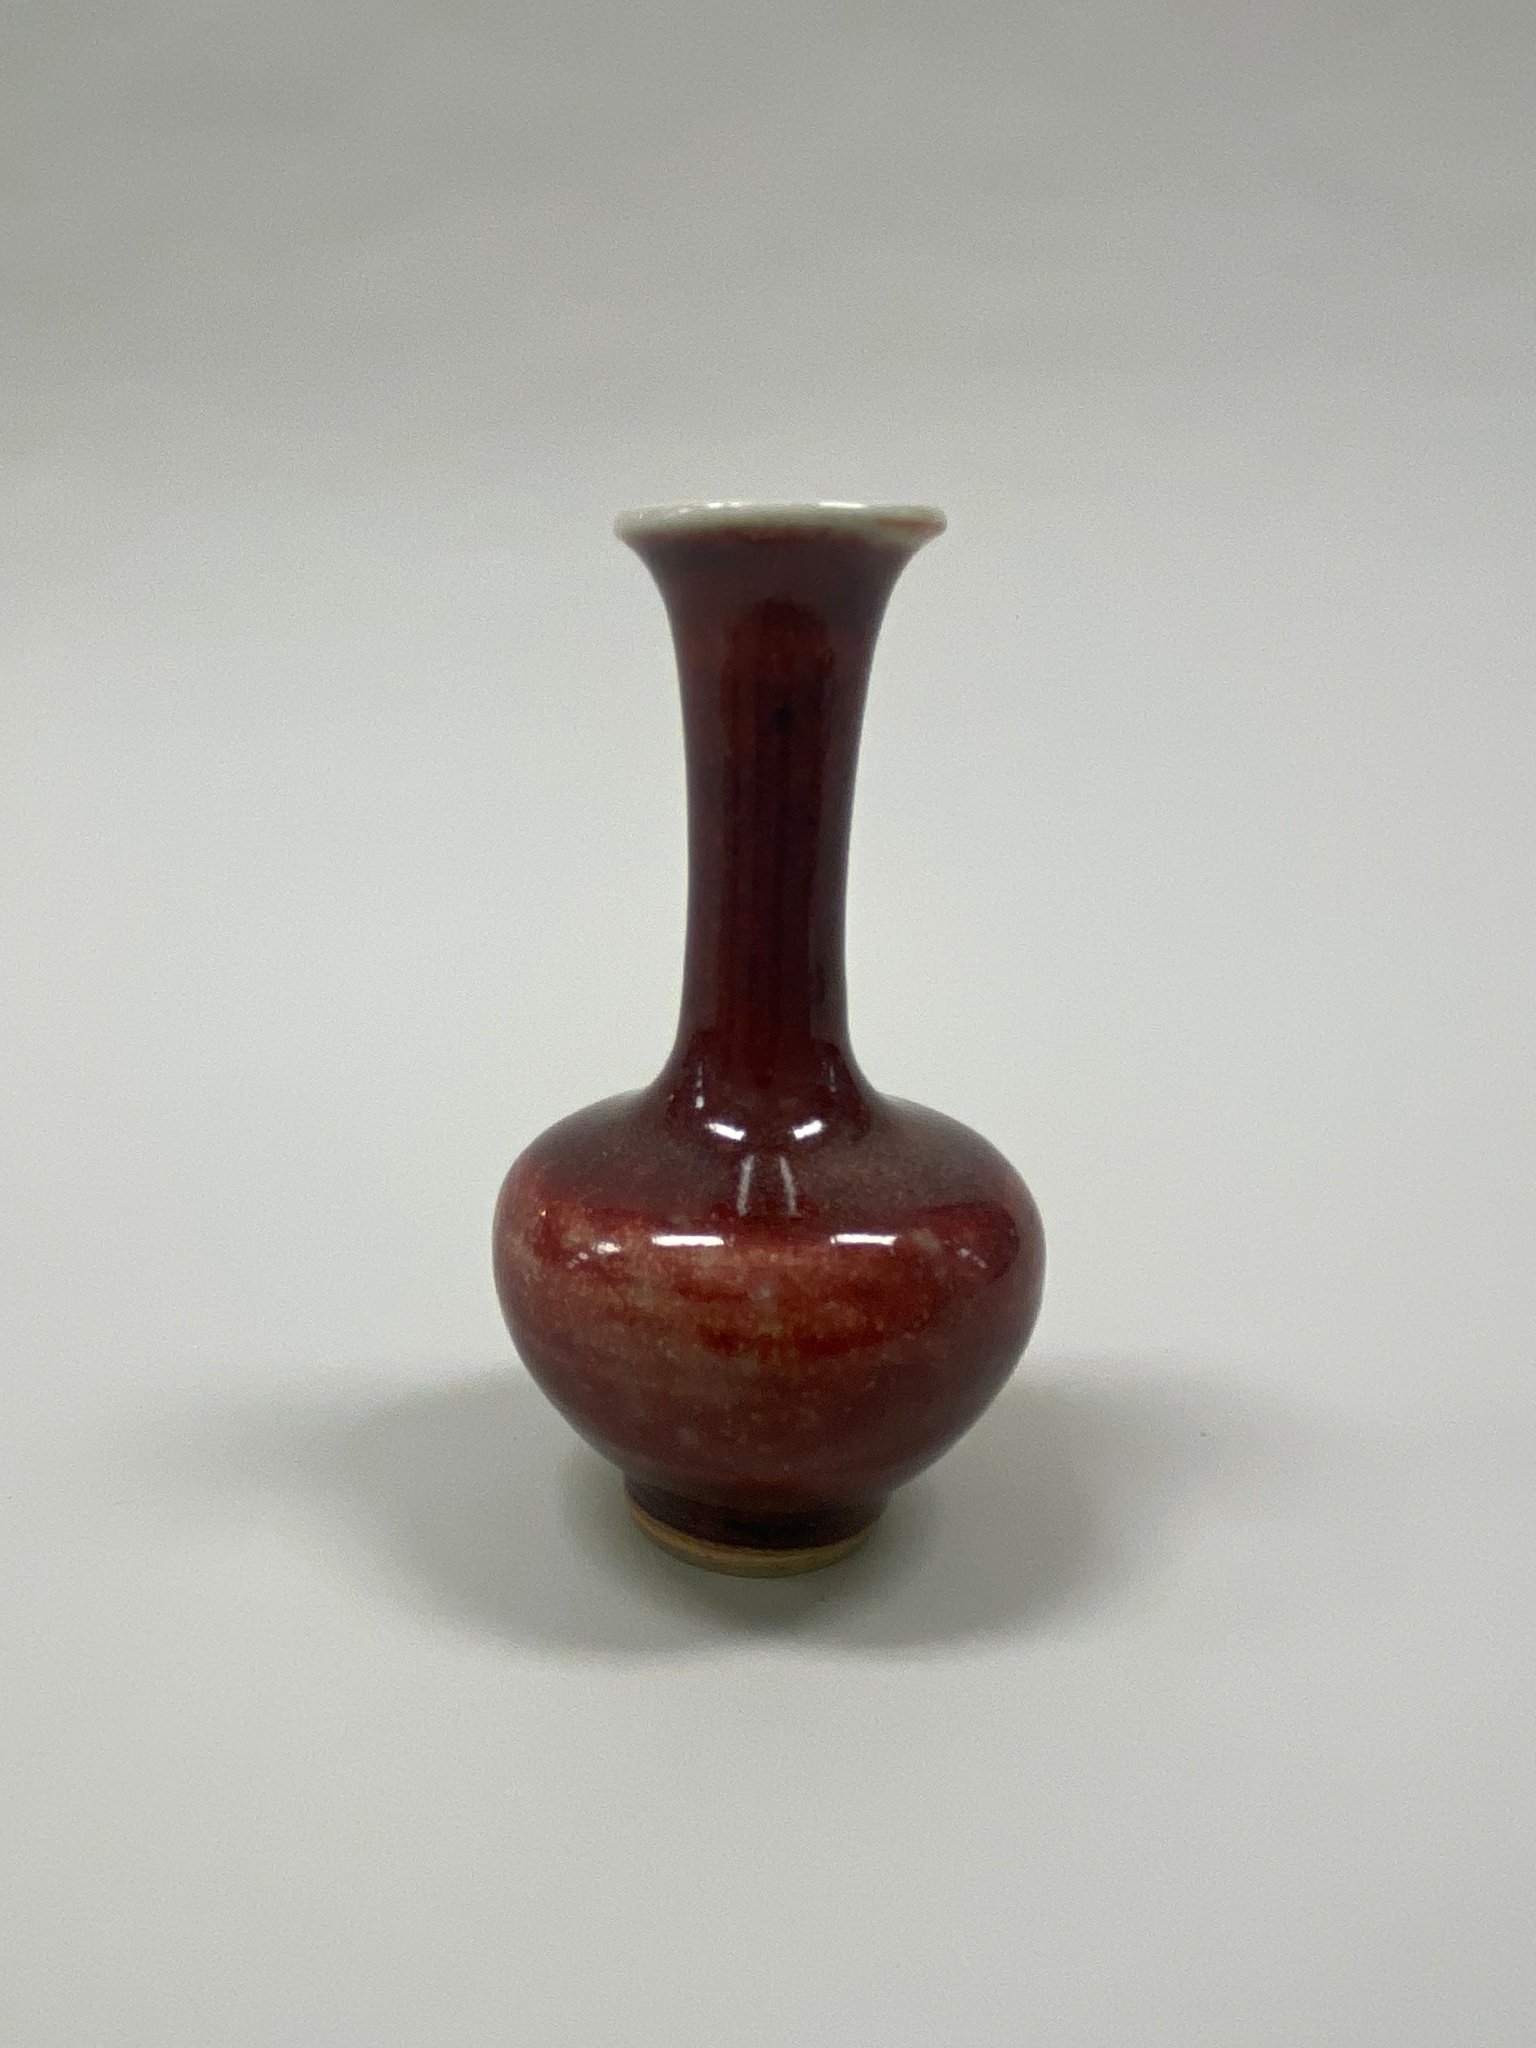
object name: vase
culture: chinese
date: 1701-1800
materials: copper, glaze, porcelain